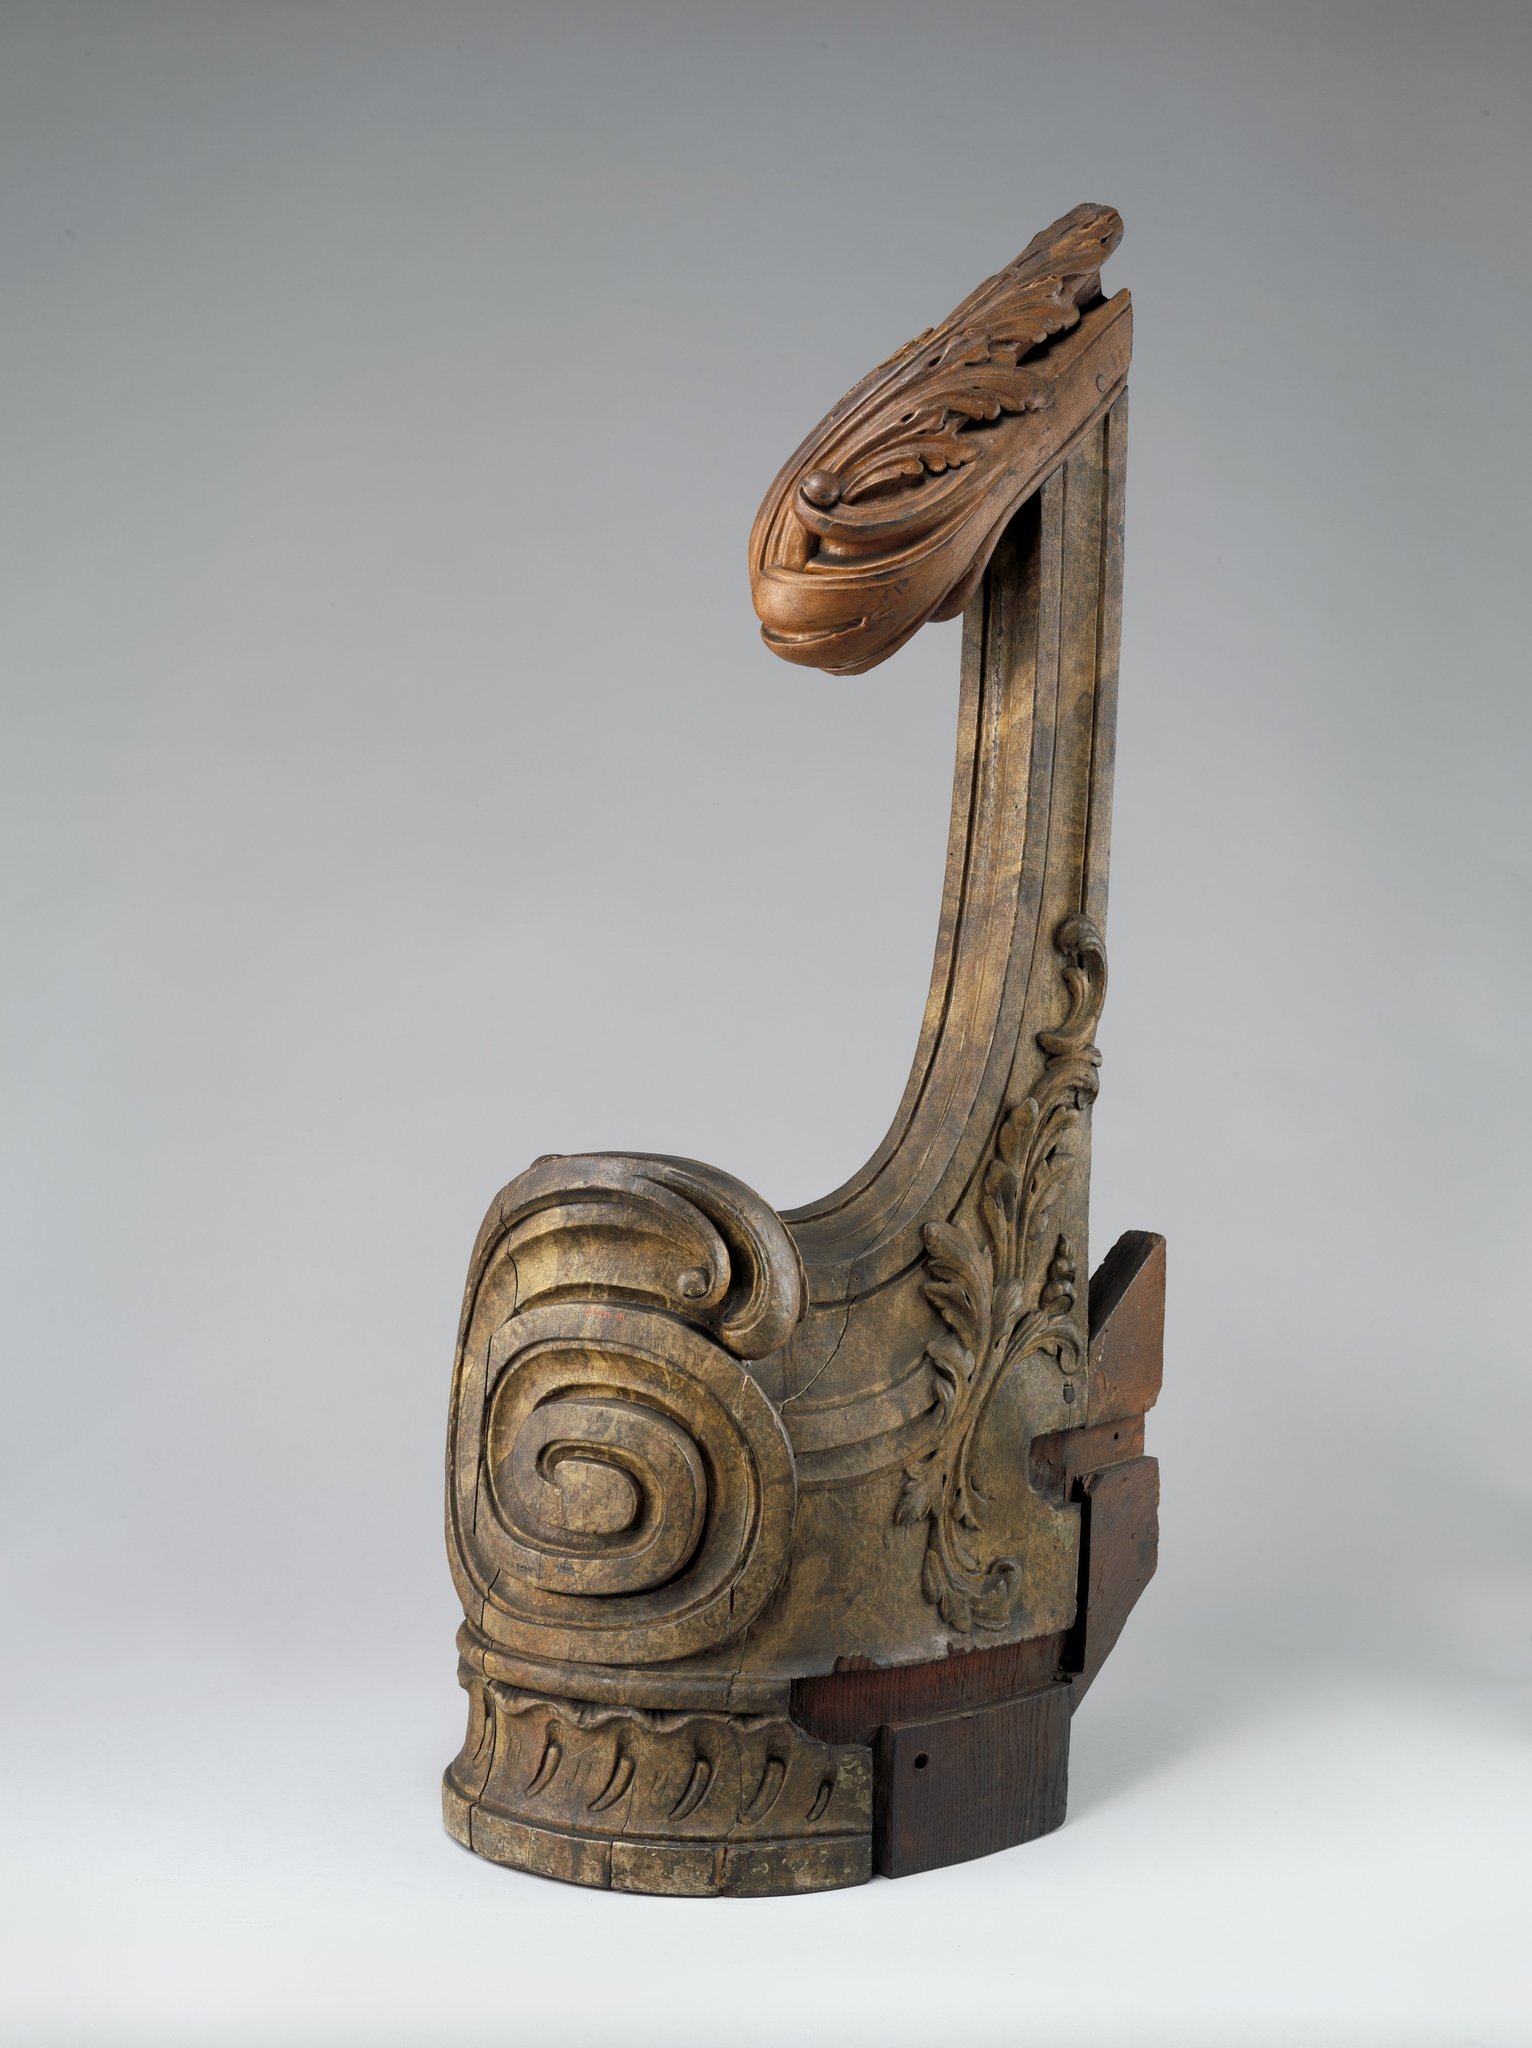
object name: newel post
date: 1701-1800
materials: marble, wood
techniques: carving, painting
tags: leaves